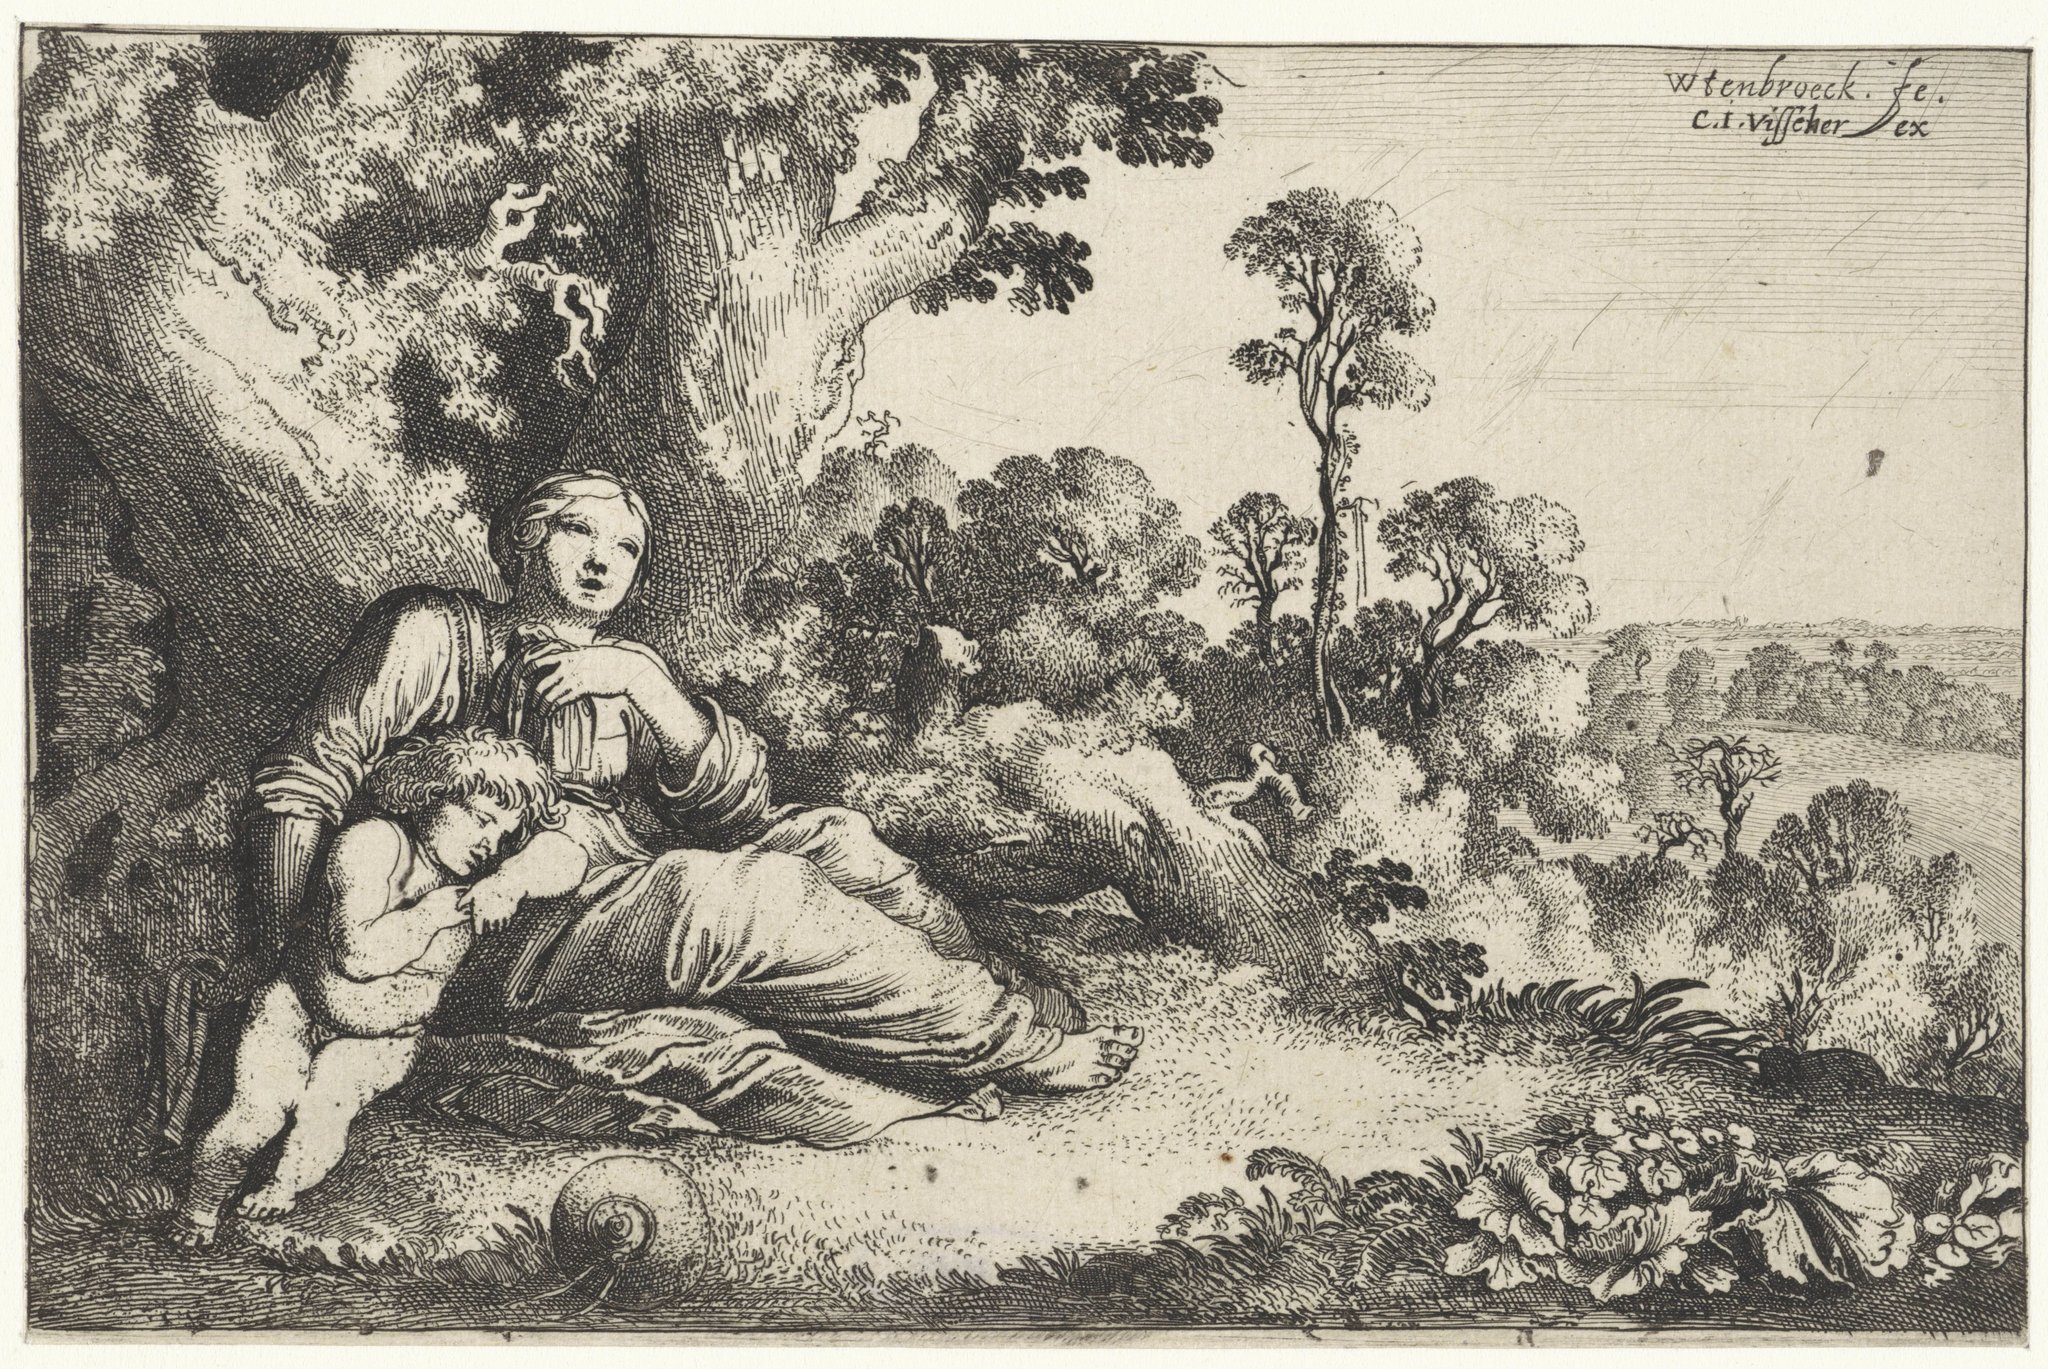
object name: print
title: Hagar en Ismaël in de woestijn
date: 1618-1652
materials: paper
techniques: engraving, etching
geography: amsterdam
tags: hagar and ishmael in the wilderness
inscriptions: collector's mark: Lugt 2610, collector's mark: Lugt 2228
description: Hagar rust aan de voet van een dikke boom. Ismaël leunt tegen haar.